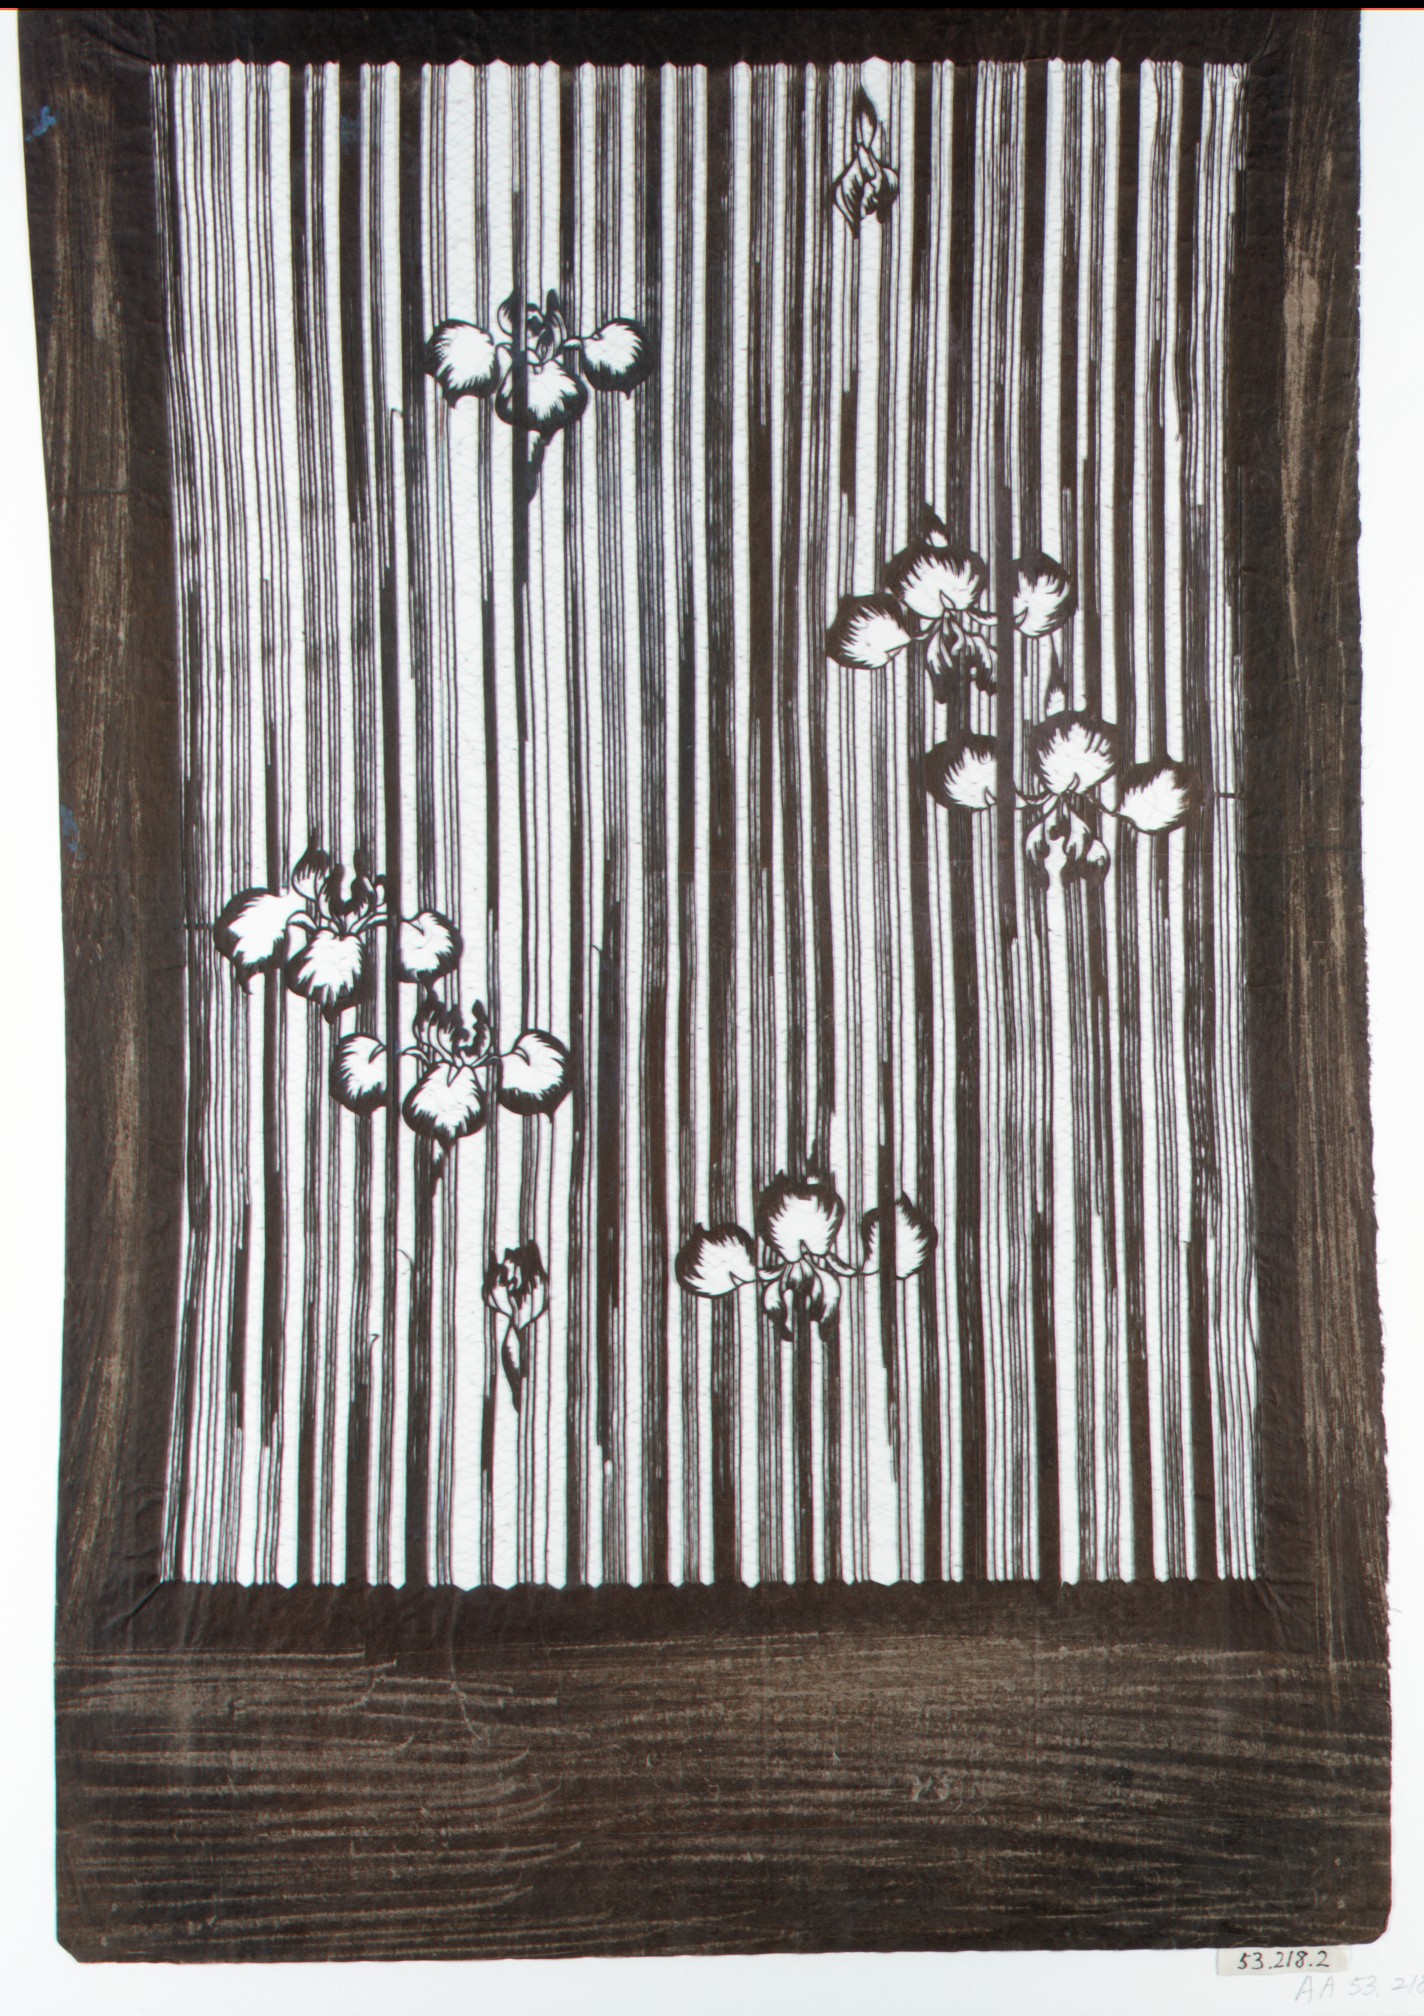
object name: stencil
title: Stencil with Design of Irises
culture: japanese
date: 1801-1833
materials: paper, silk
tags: flowers